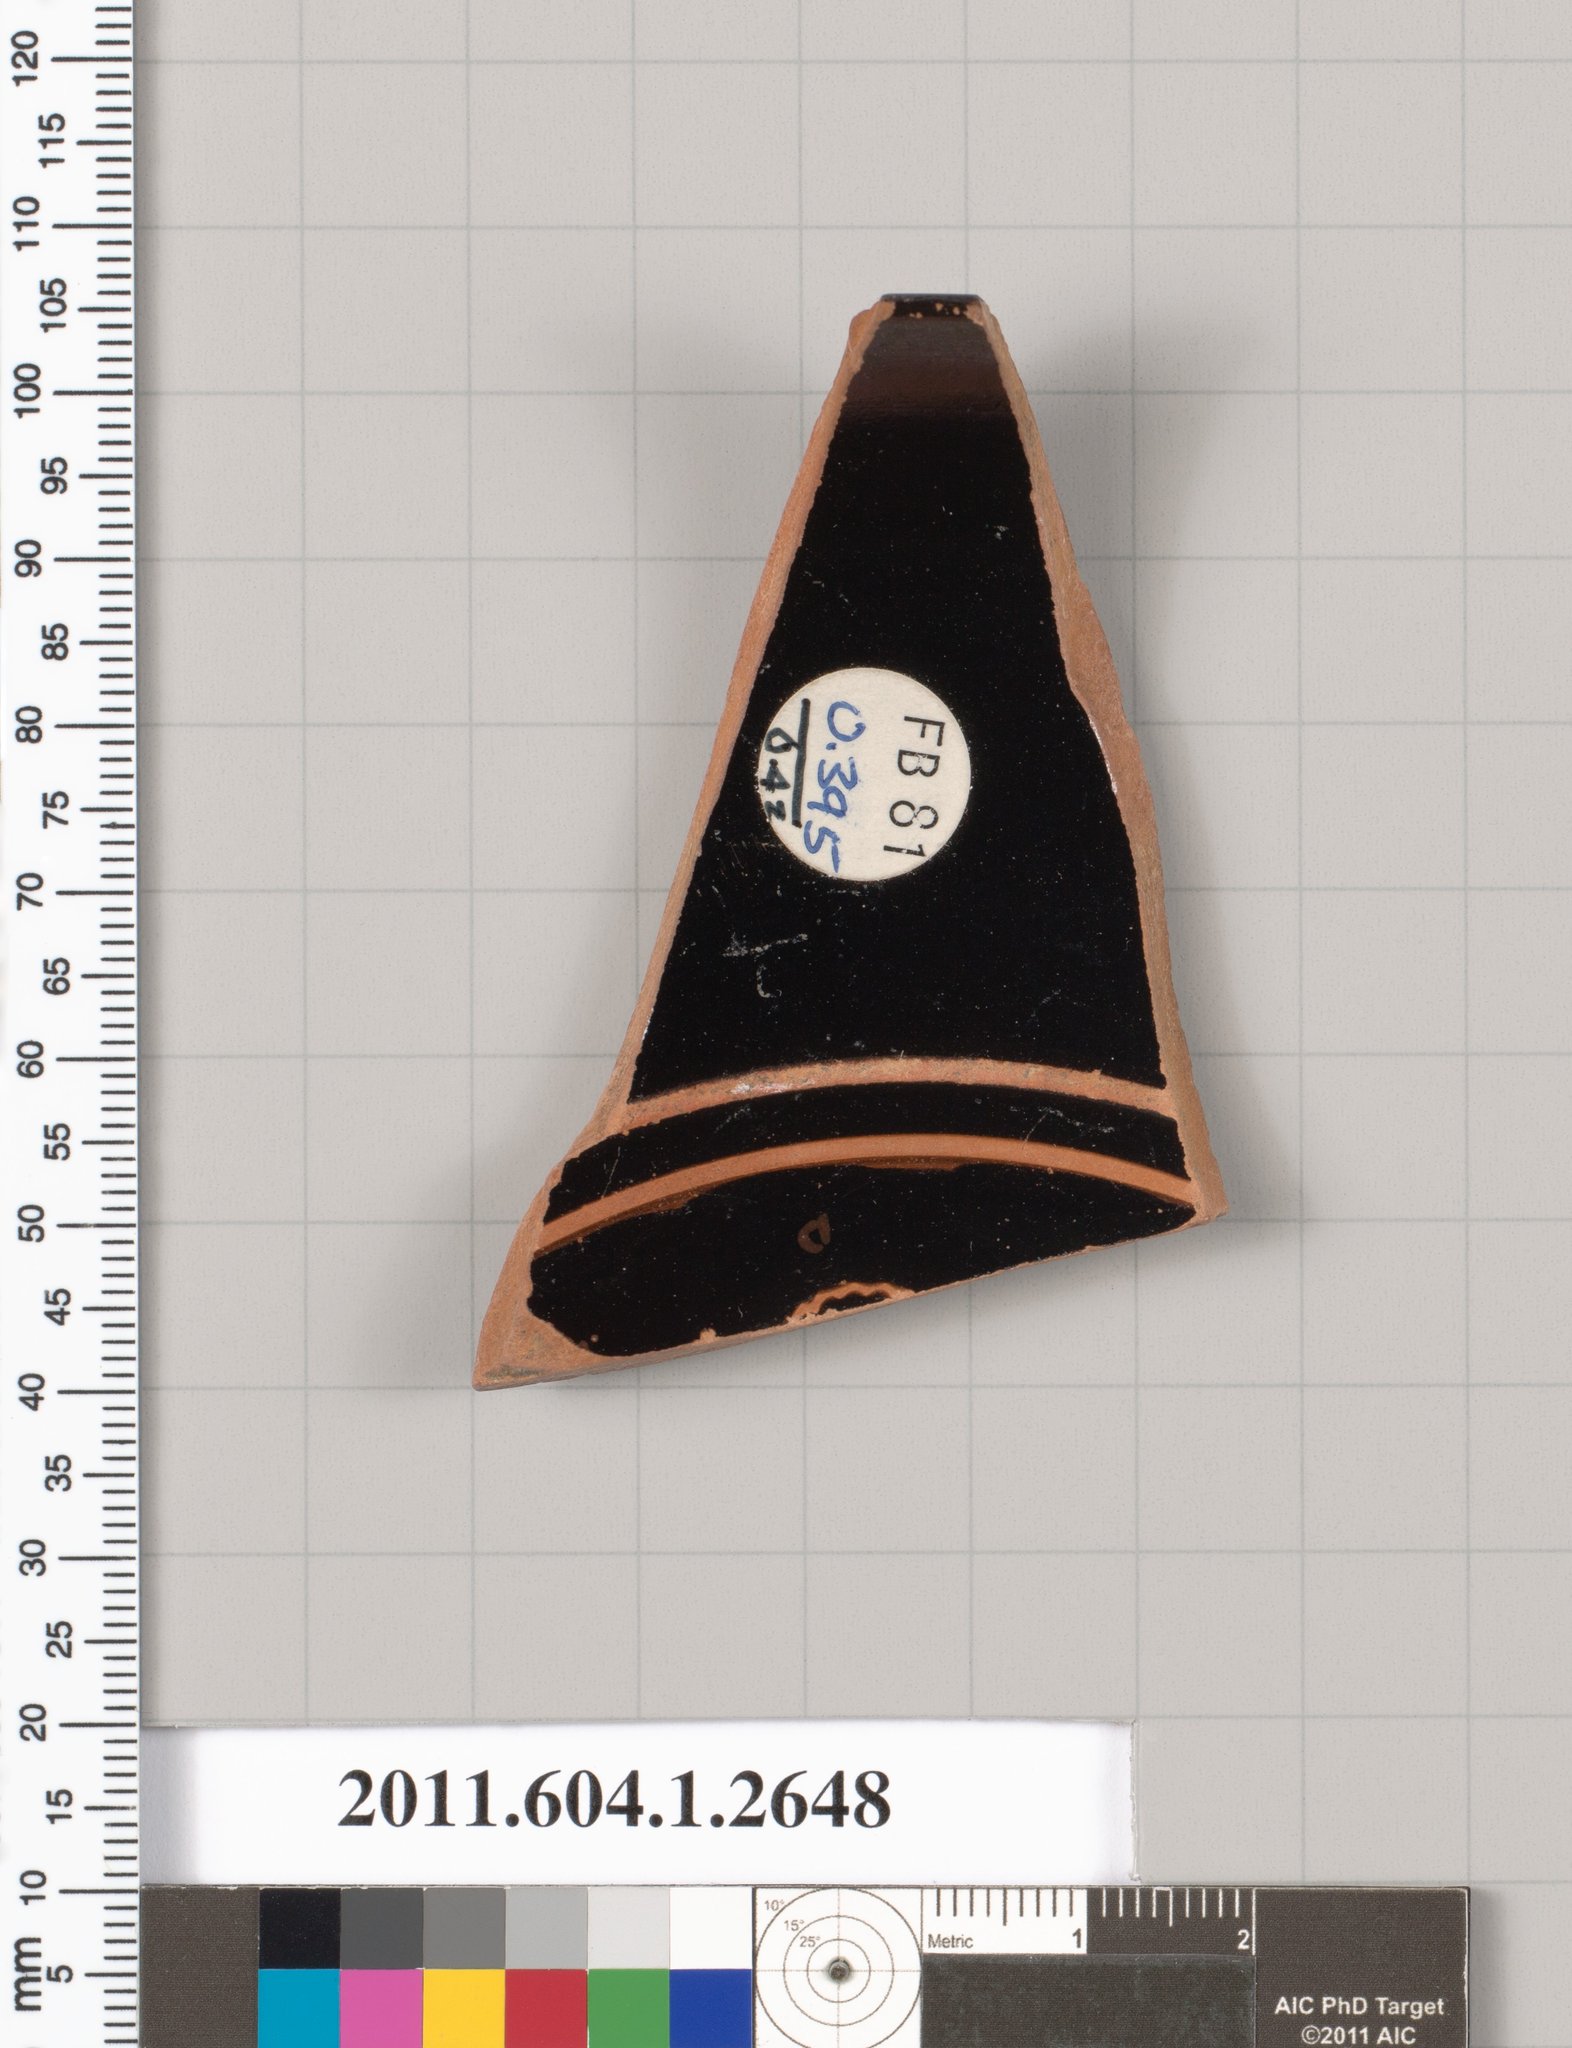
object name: kylix fragment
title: Terracotta rim fragment of a kylix (drinking cup)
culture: greek, attic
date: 520-500 BCE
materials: terracotta